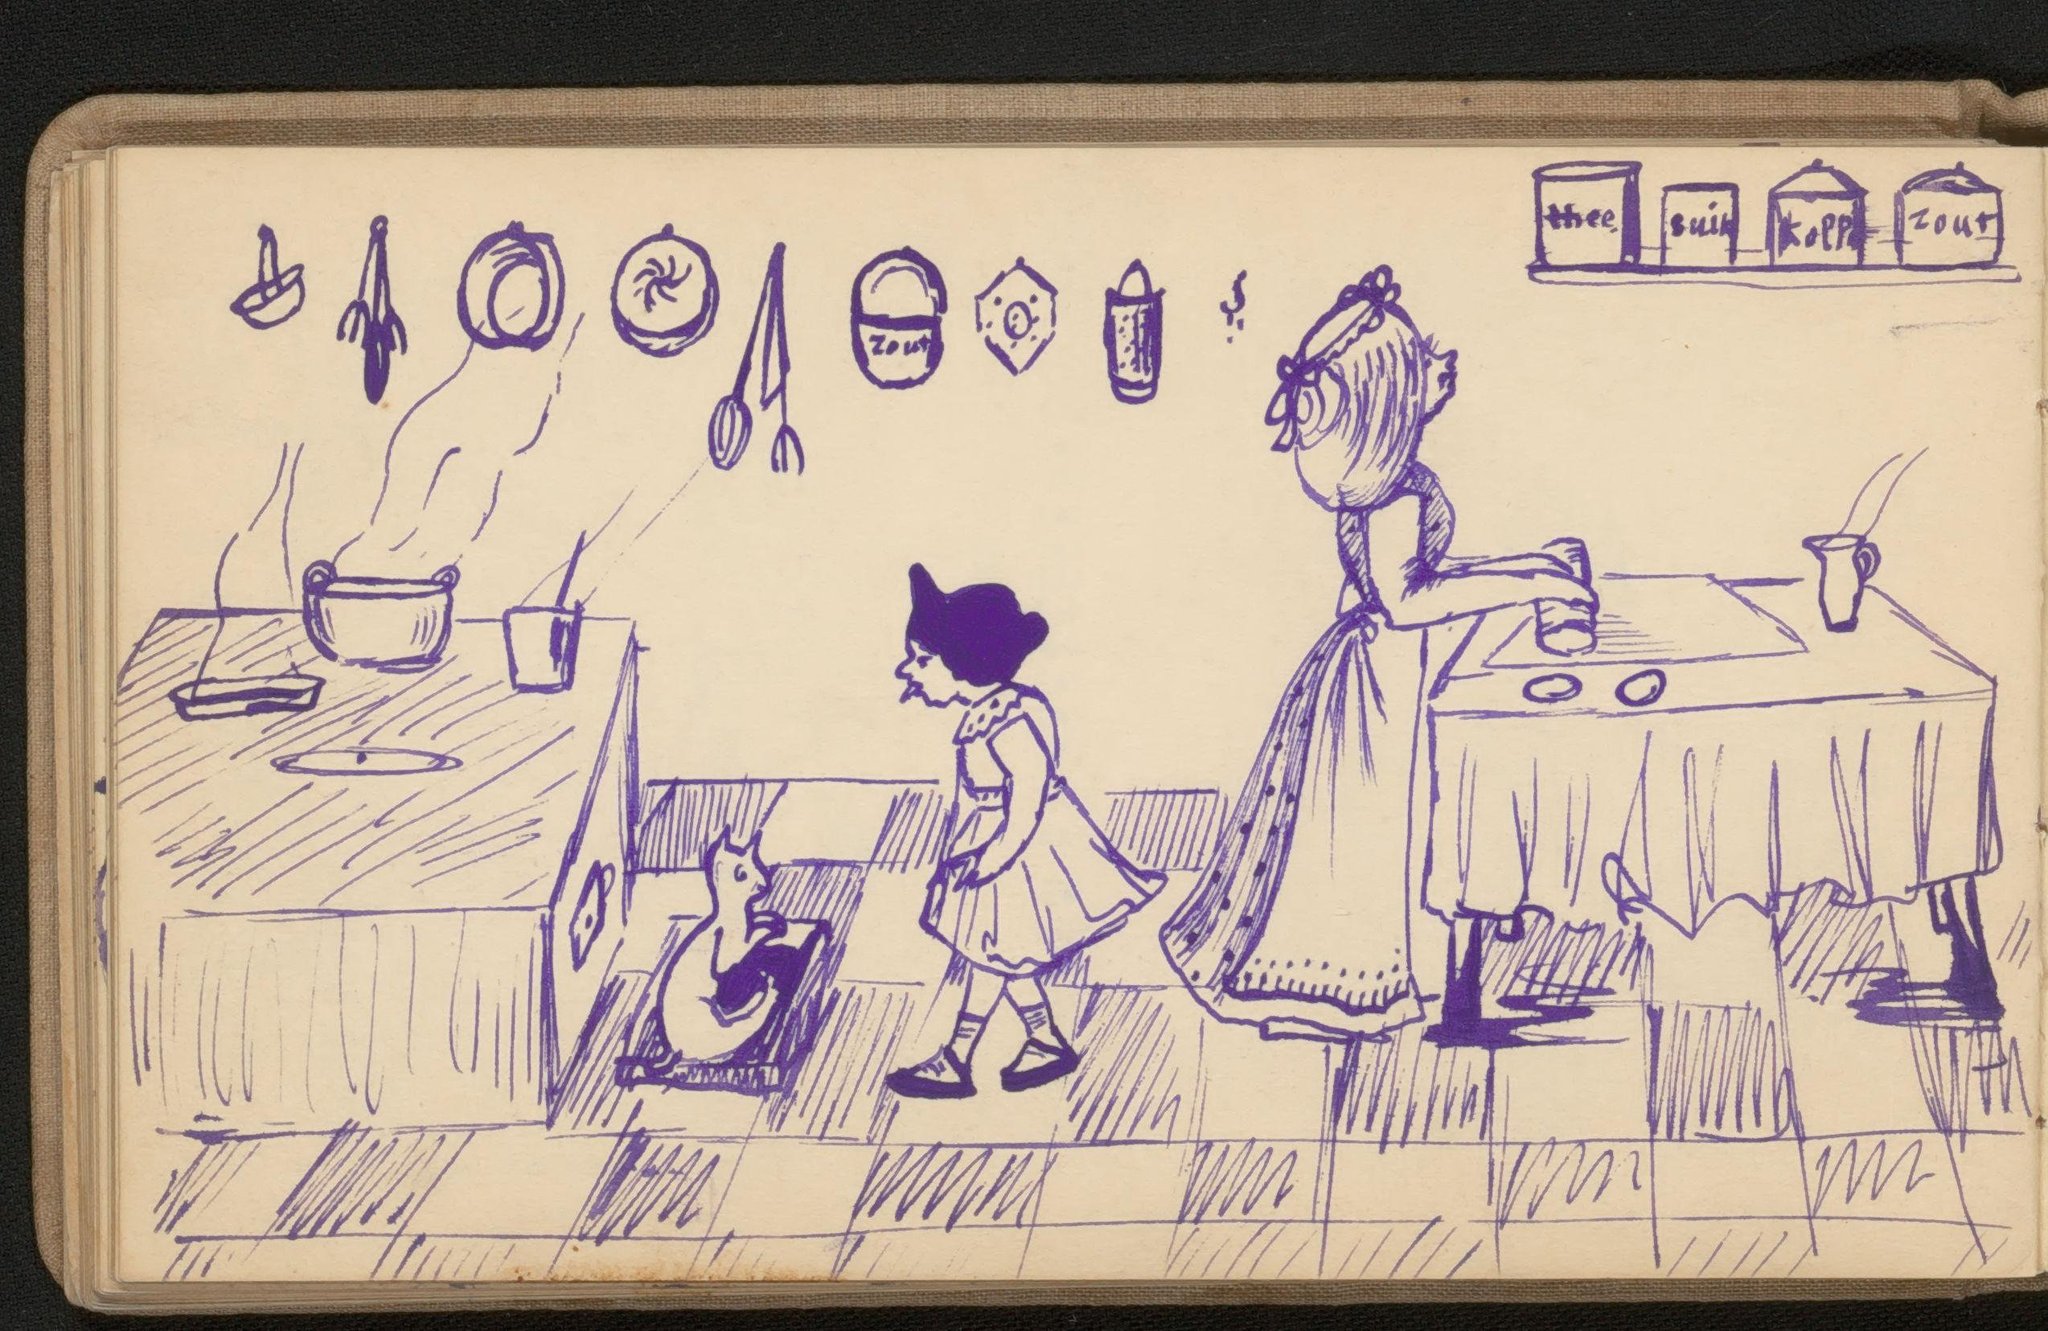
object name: sketchbook leaf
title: In de keuken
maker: Anonymous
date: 1875-1920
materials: ink, paper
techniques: pen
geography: netherlands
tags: kitchen-interior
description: Keuken. Onderdeel van het schetsboek met humoristische tekeningen over het leven van een 'famille nombreuse'. Onderwerpsrubrieken binnen de Atlas Zeden en Gewoonten: Zeden en Gewoonten in Engeren Zin, Des menschen beging, midden en einde, Kinderleven.